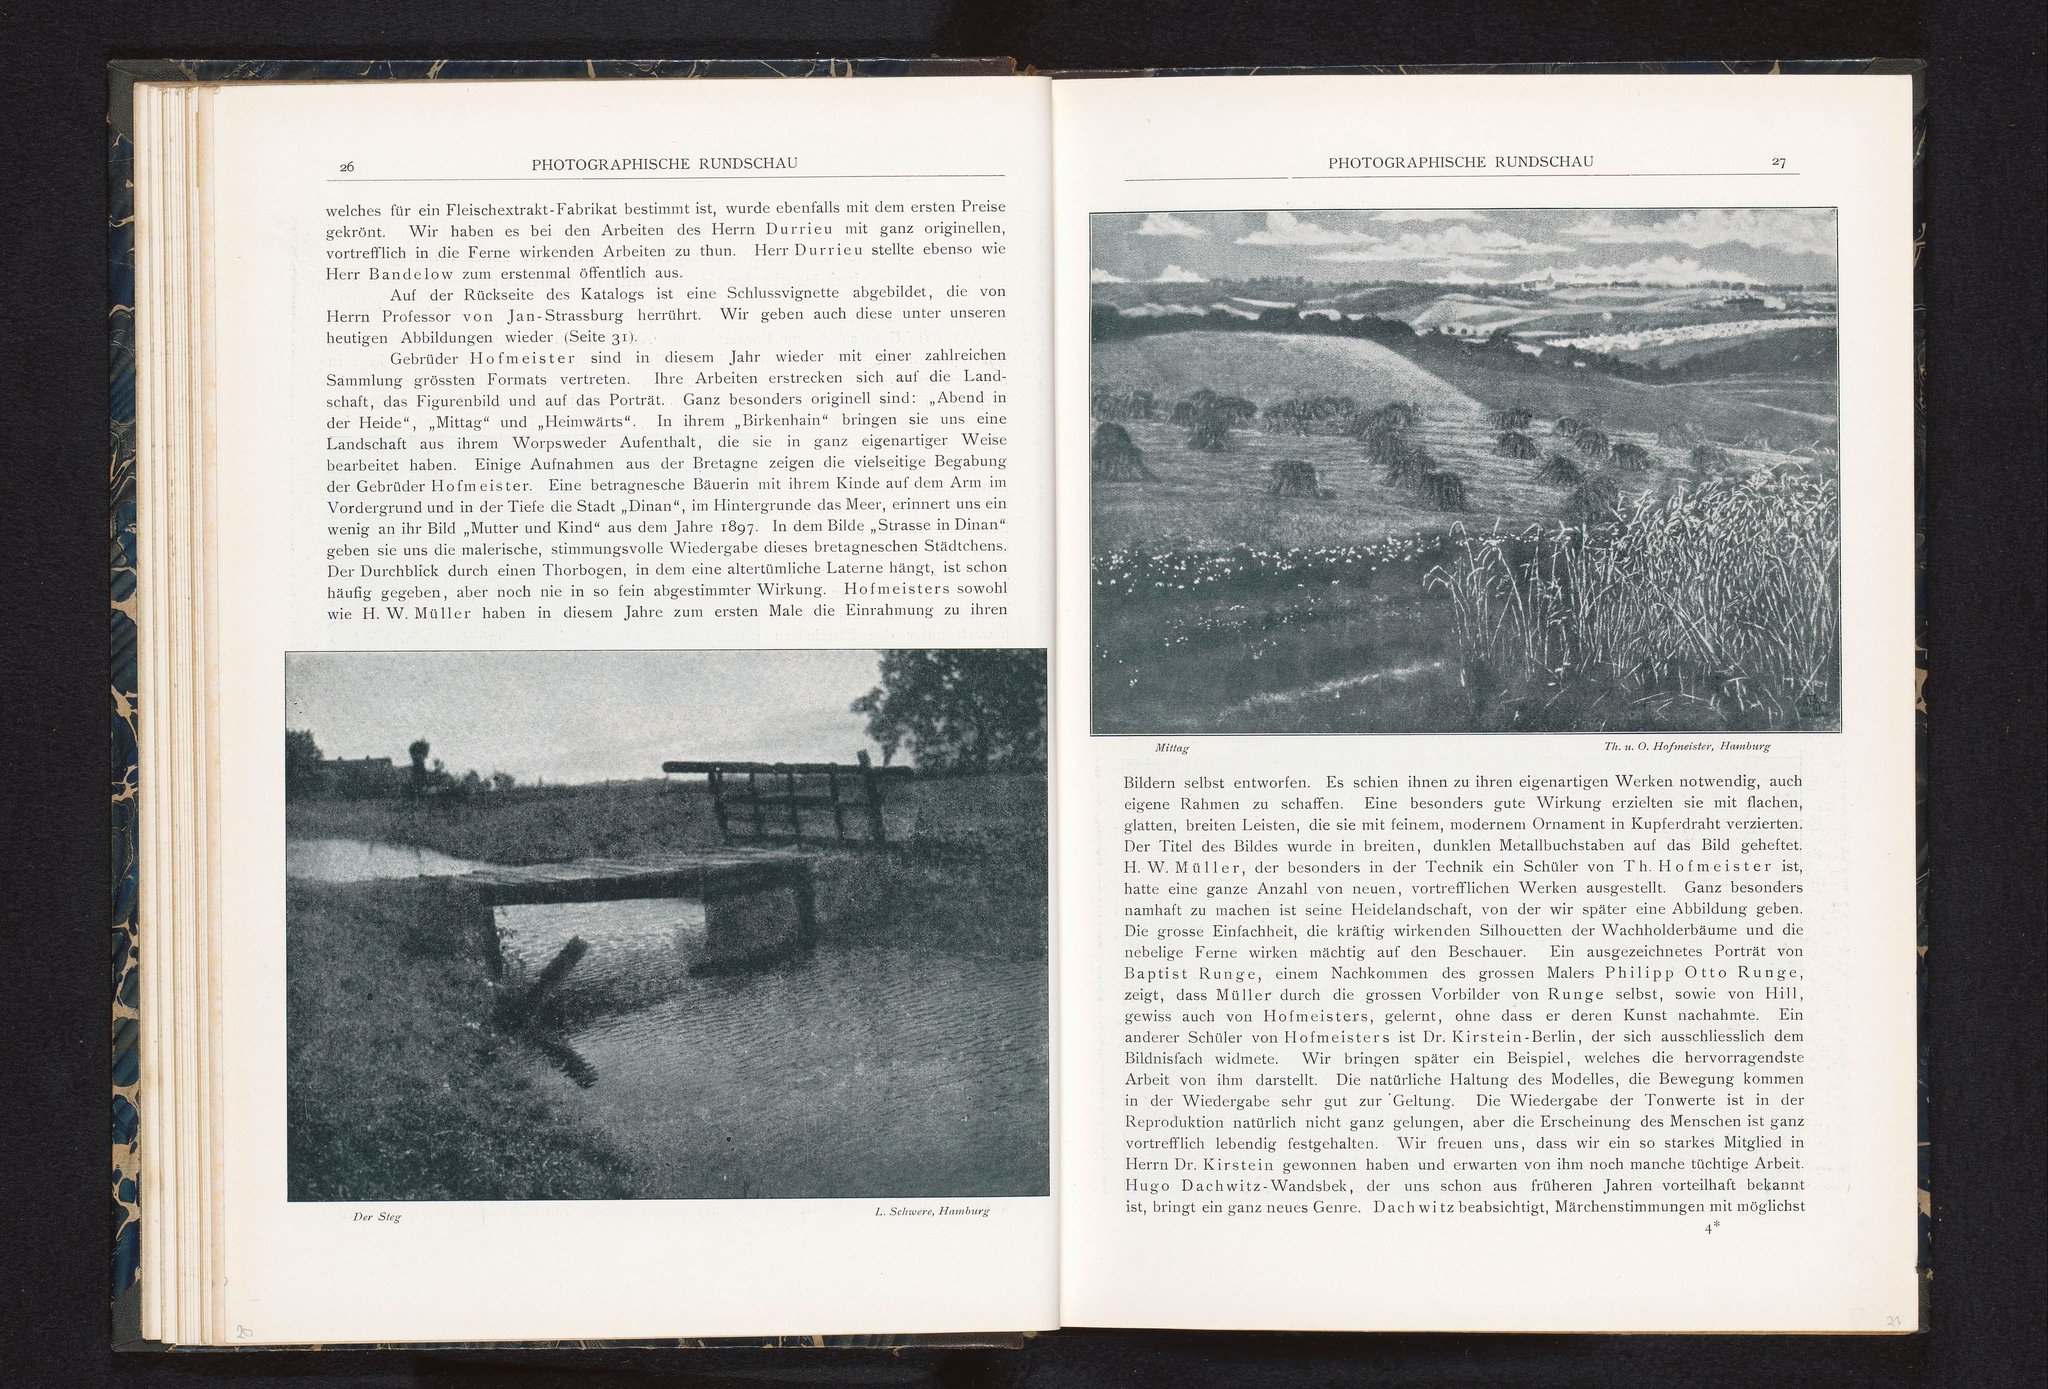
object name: page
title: Der Steg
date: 1896-1901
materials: paper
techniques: autotype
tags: bridge, small canal, ditch